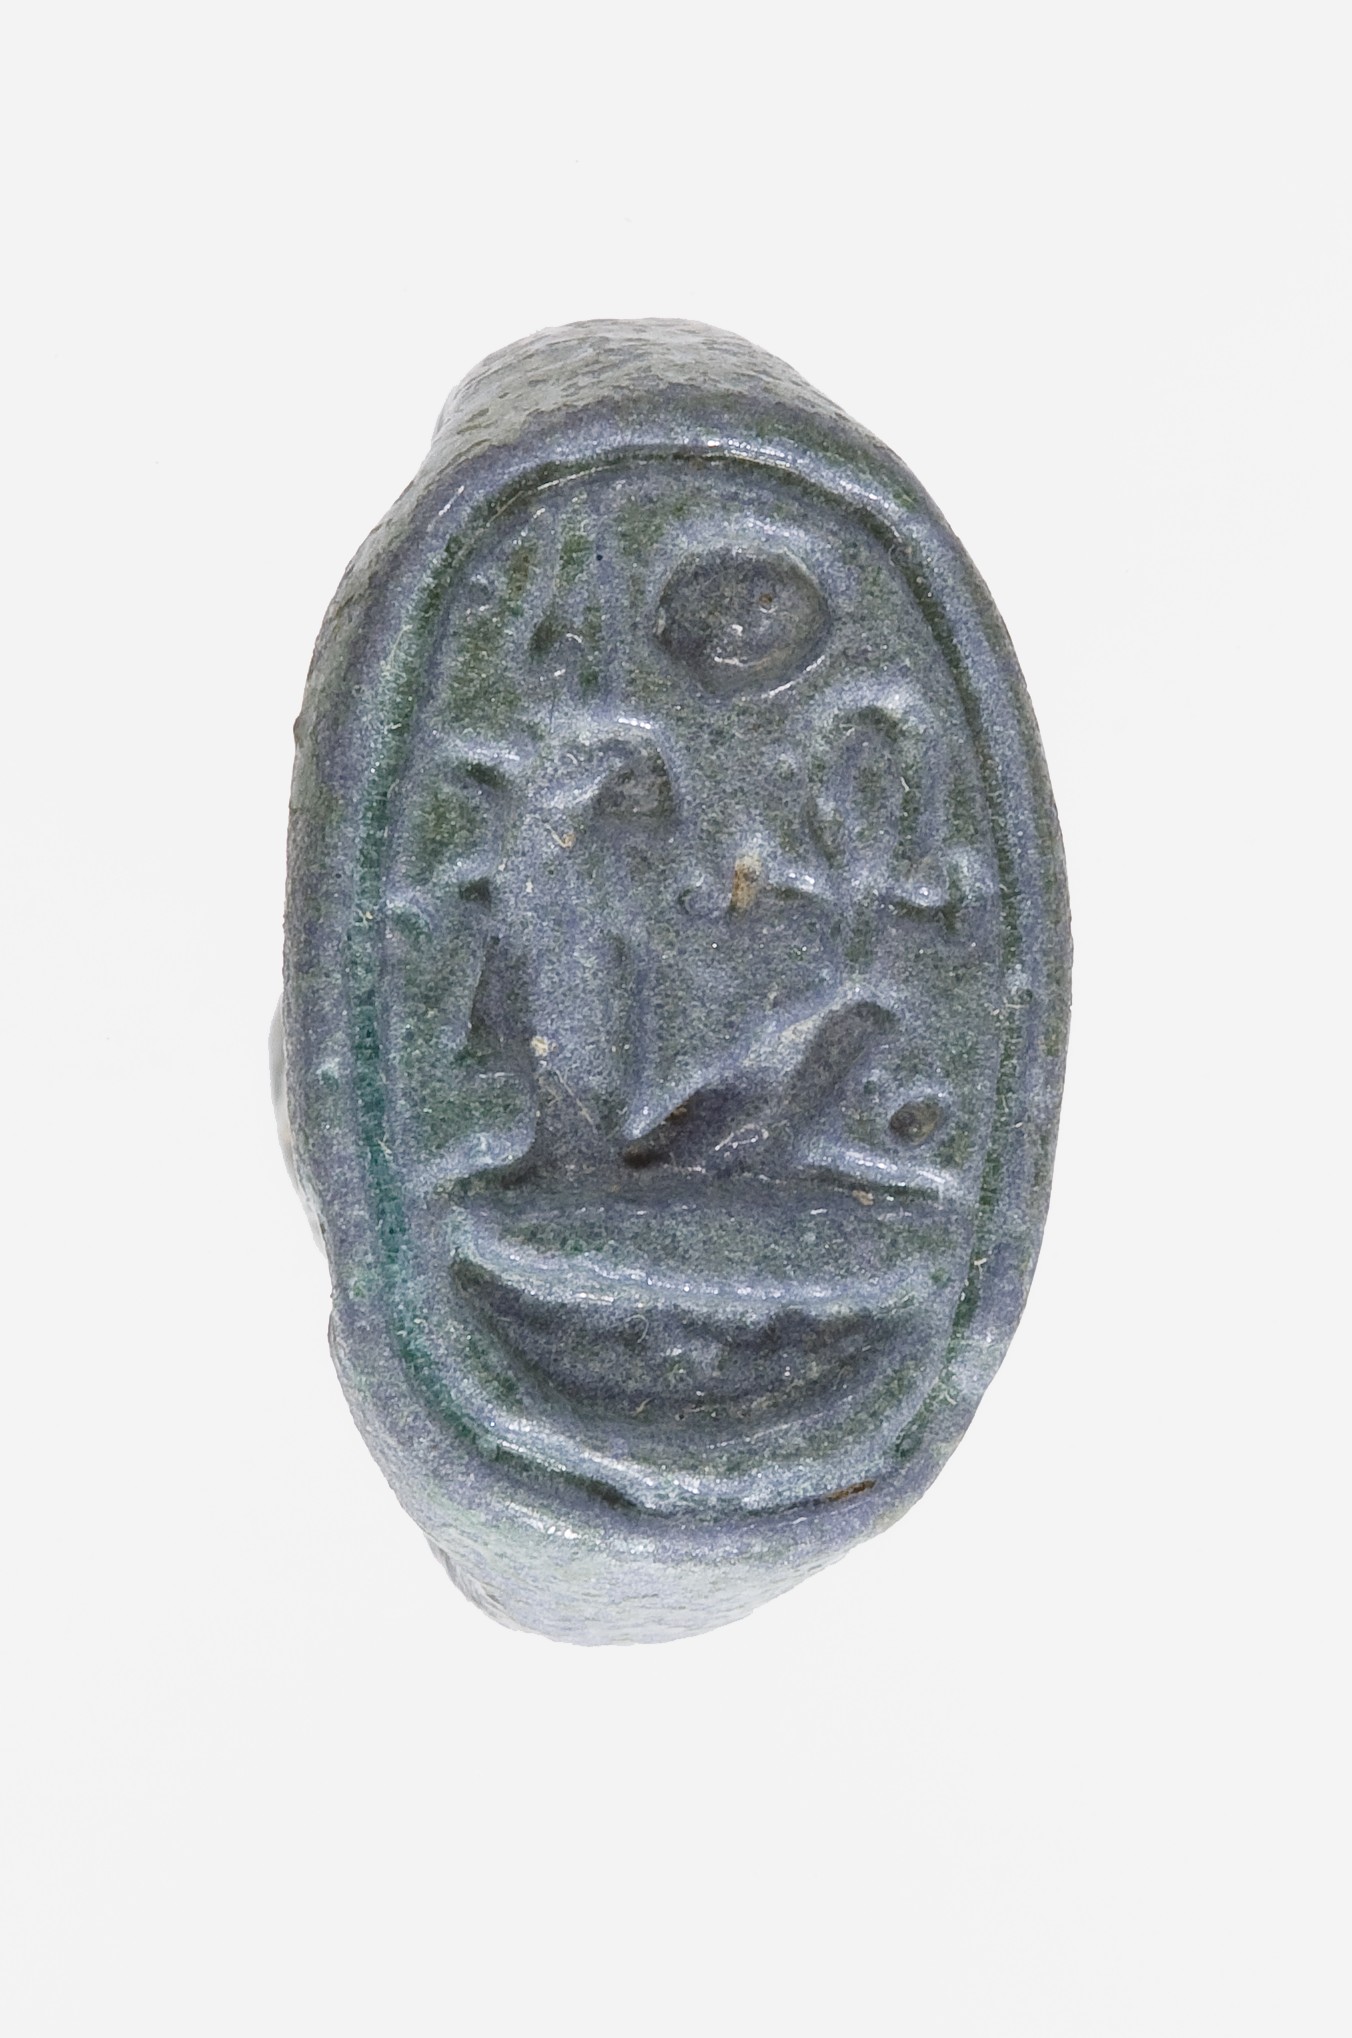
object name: ring, amenhotep iii, nebmaatre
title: Ring Inscribed with the Throne Name of Amenhotep III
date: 1390-1352 BCE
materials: faience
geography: egypt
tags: hieroglyphs